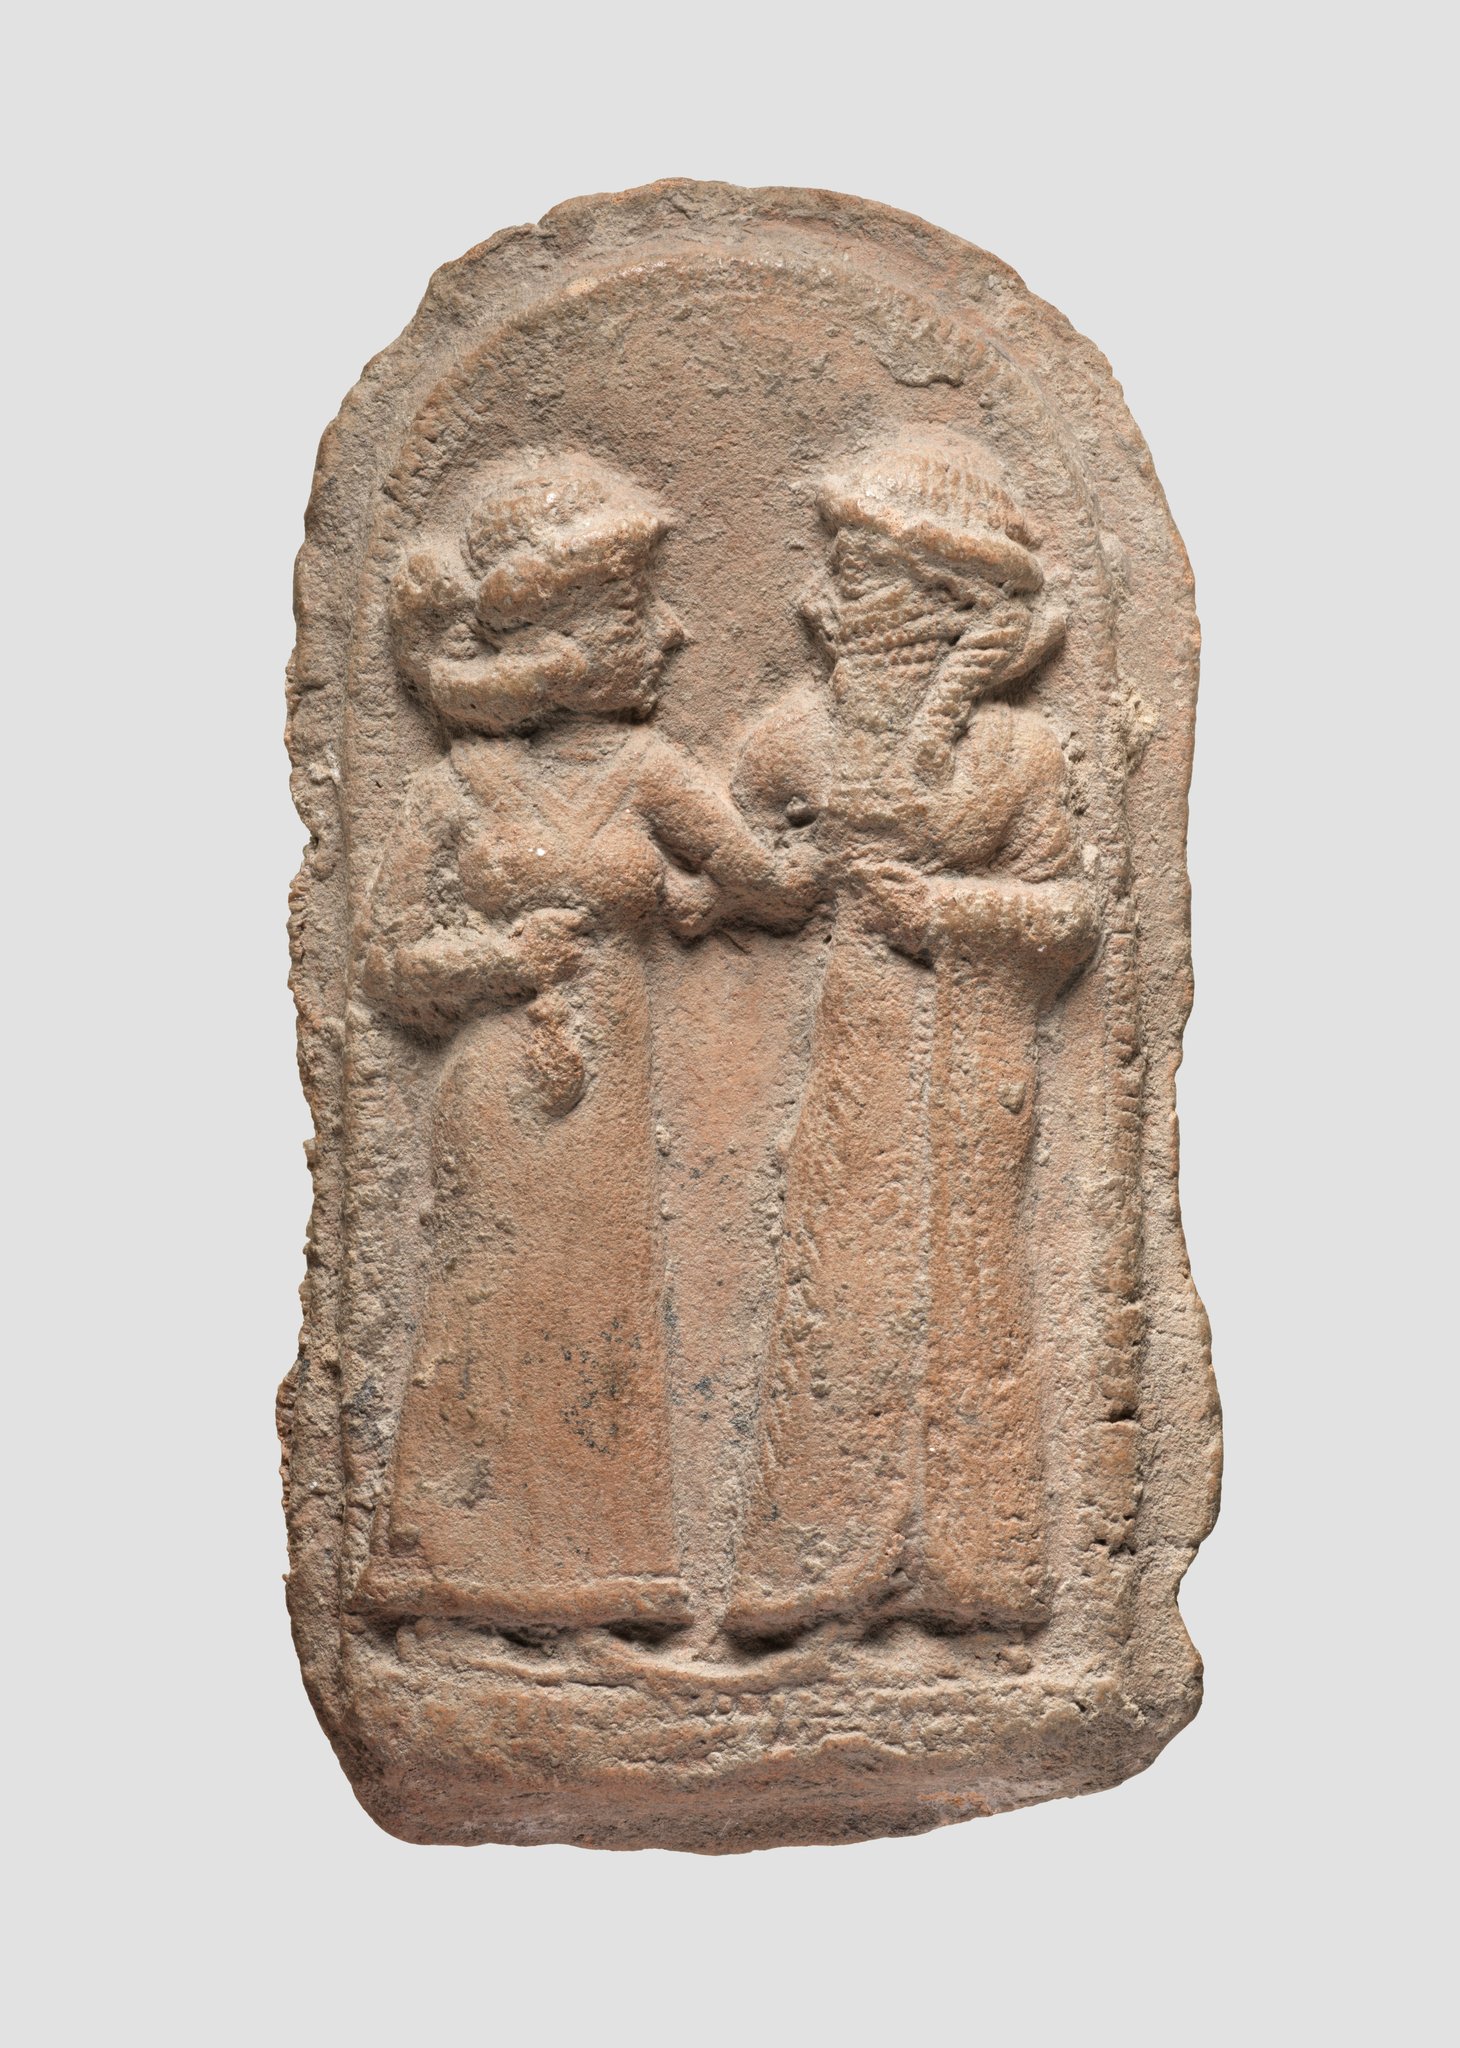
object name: relief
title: Molded plaque: couple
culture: isin-larsa–old babylonian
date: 2000-1700 BCE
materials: ceramic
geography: southern mesopotamia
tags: couples